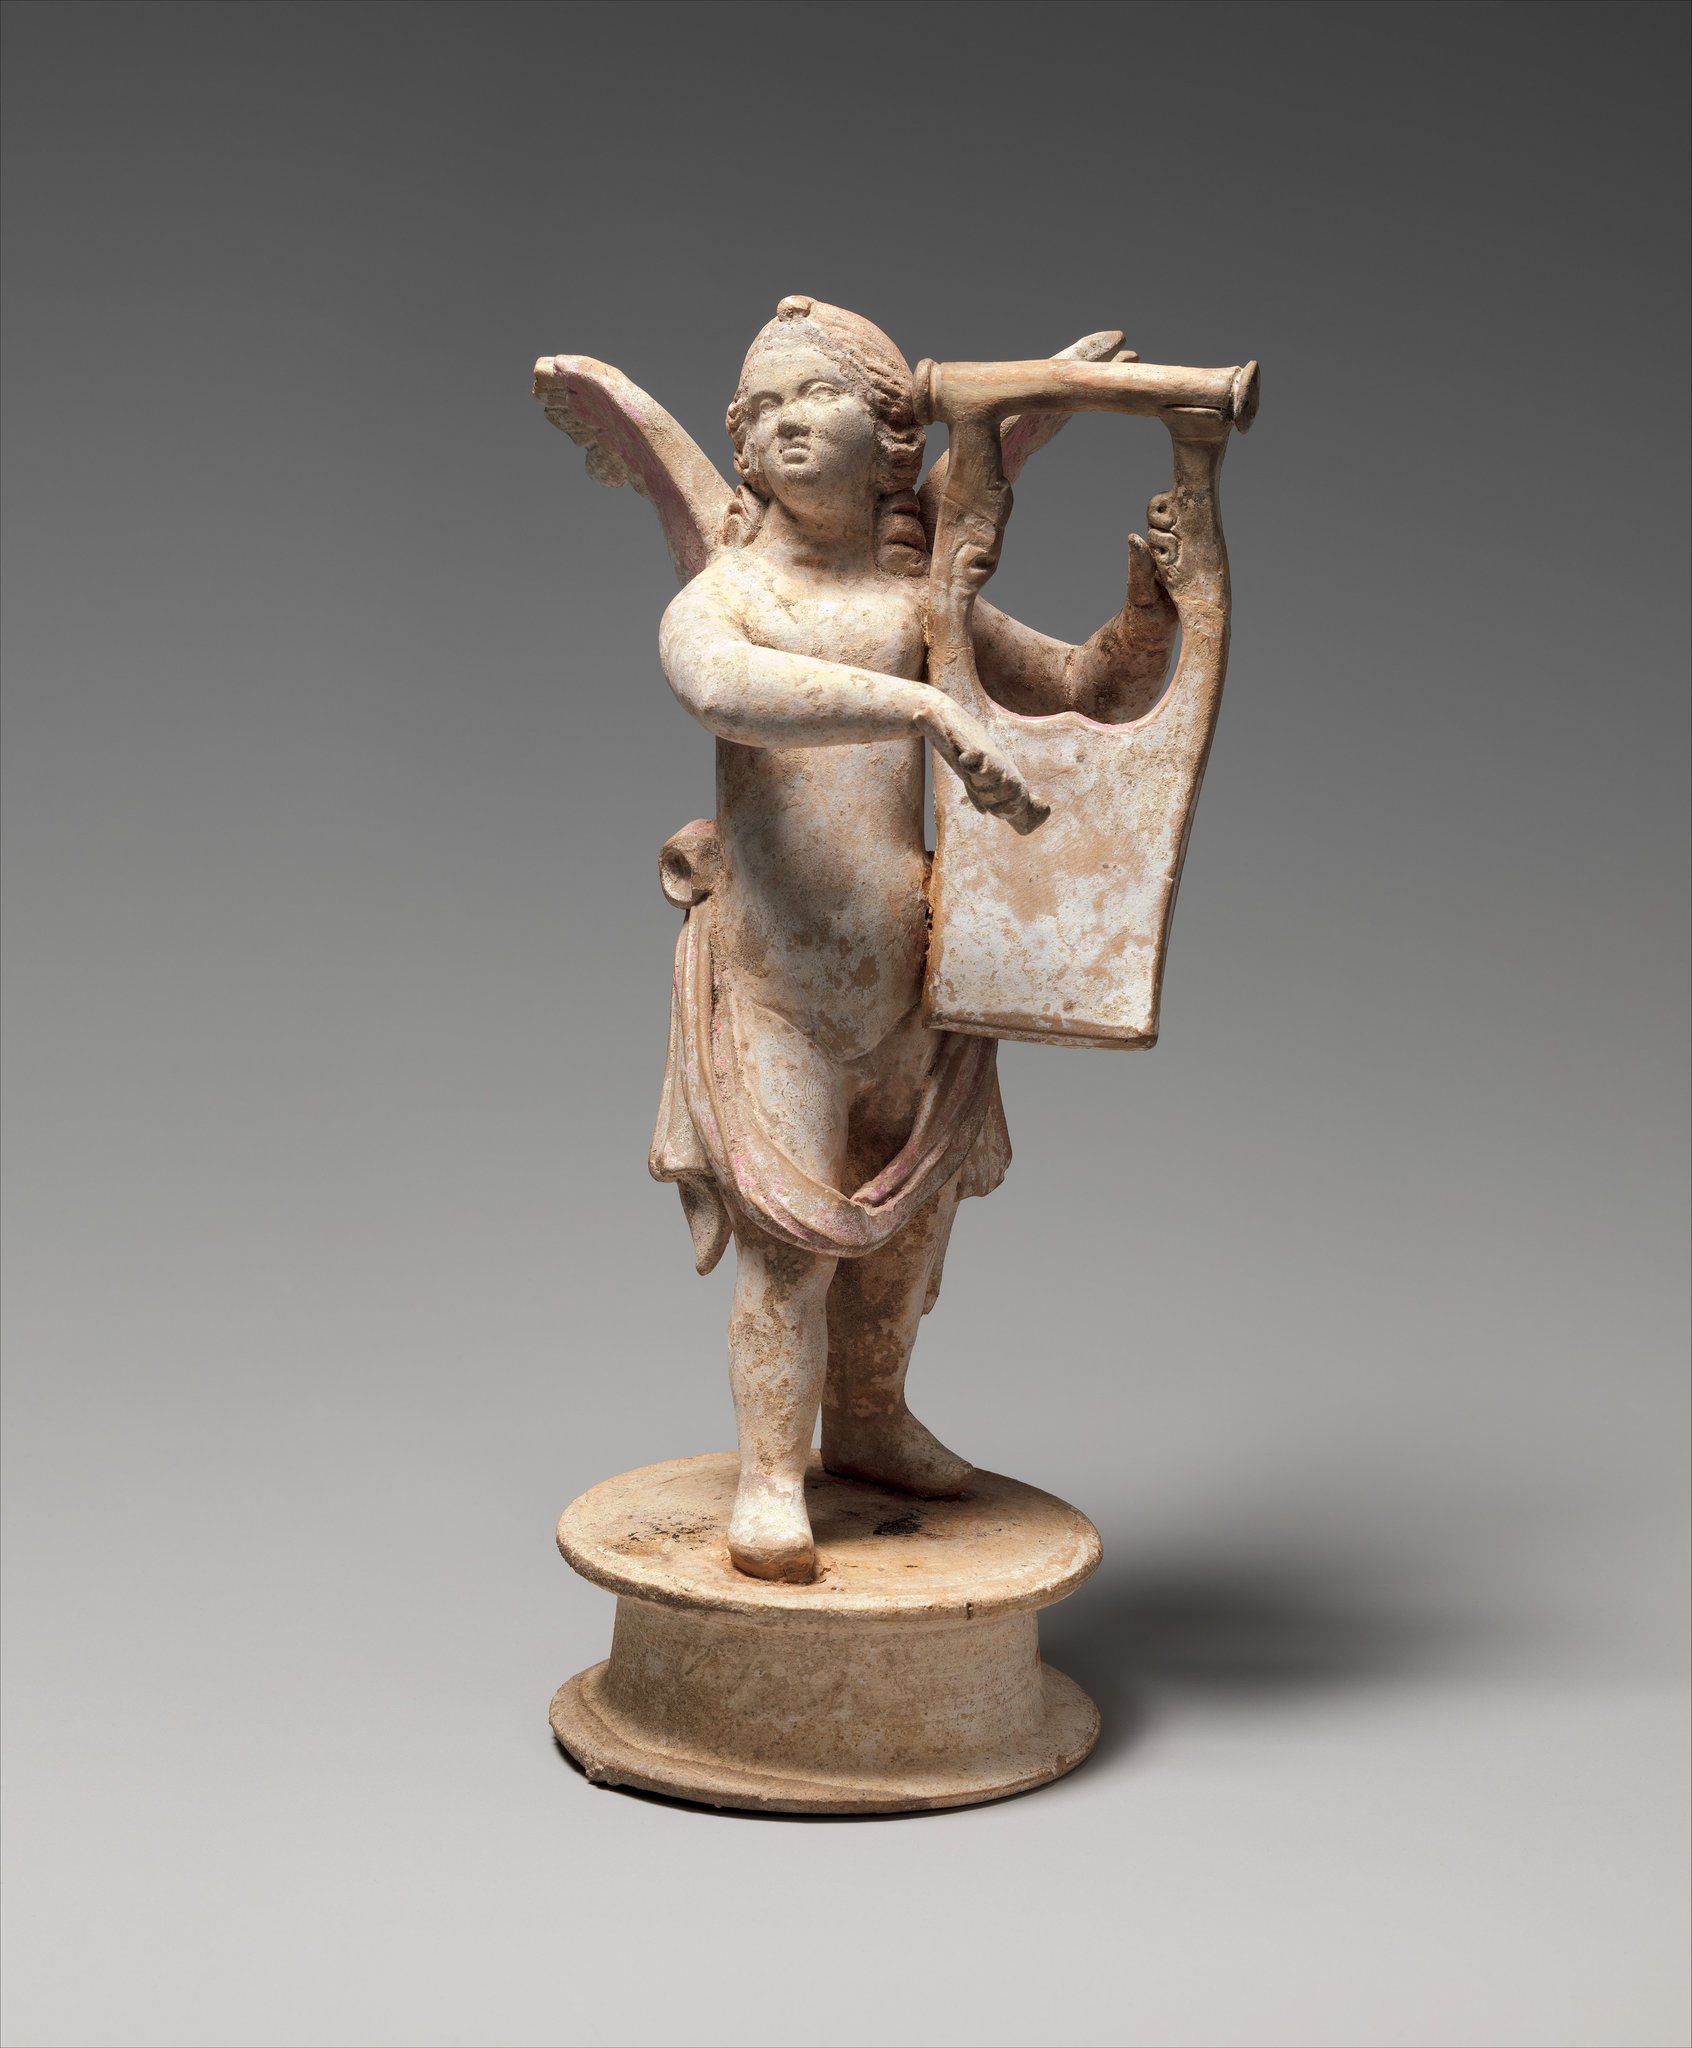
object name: statuette of eros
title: Terracotta statuette of Eros playing a lyre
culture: greek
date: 300-101 BCE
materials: terracotta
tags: musical instruments,eros